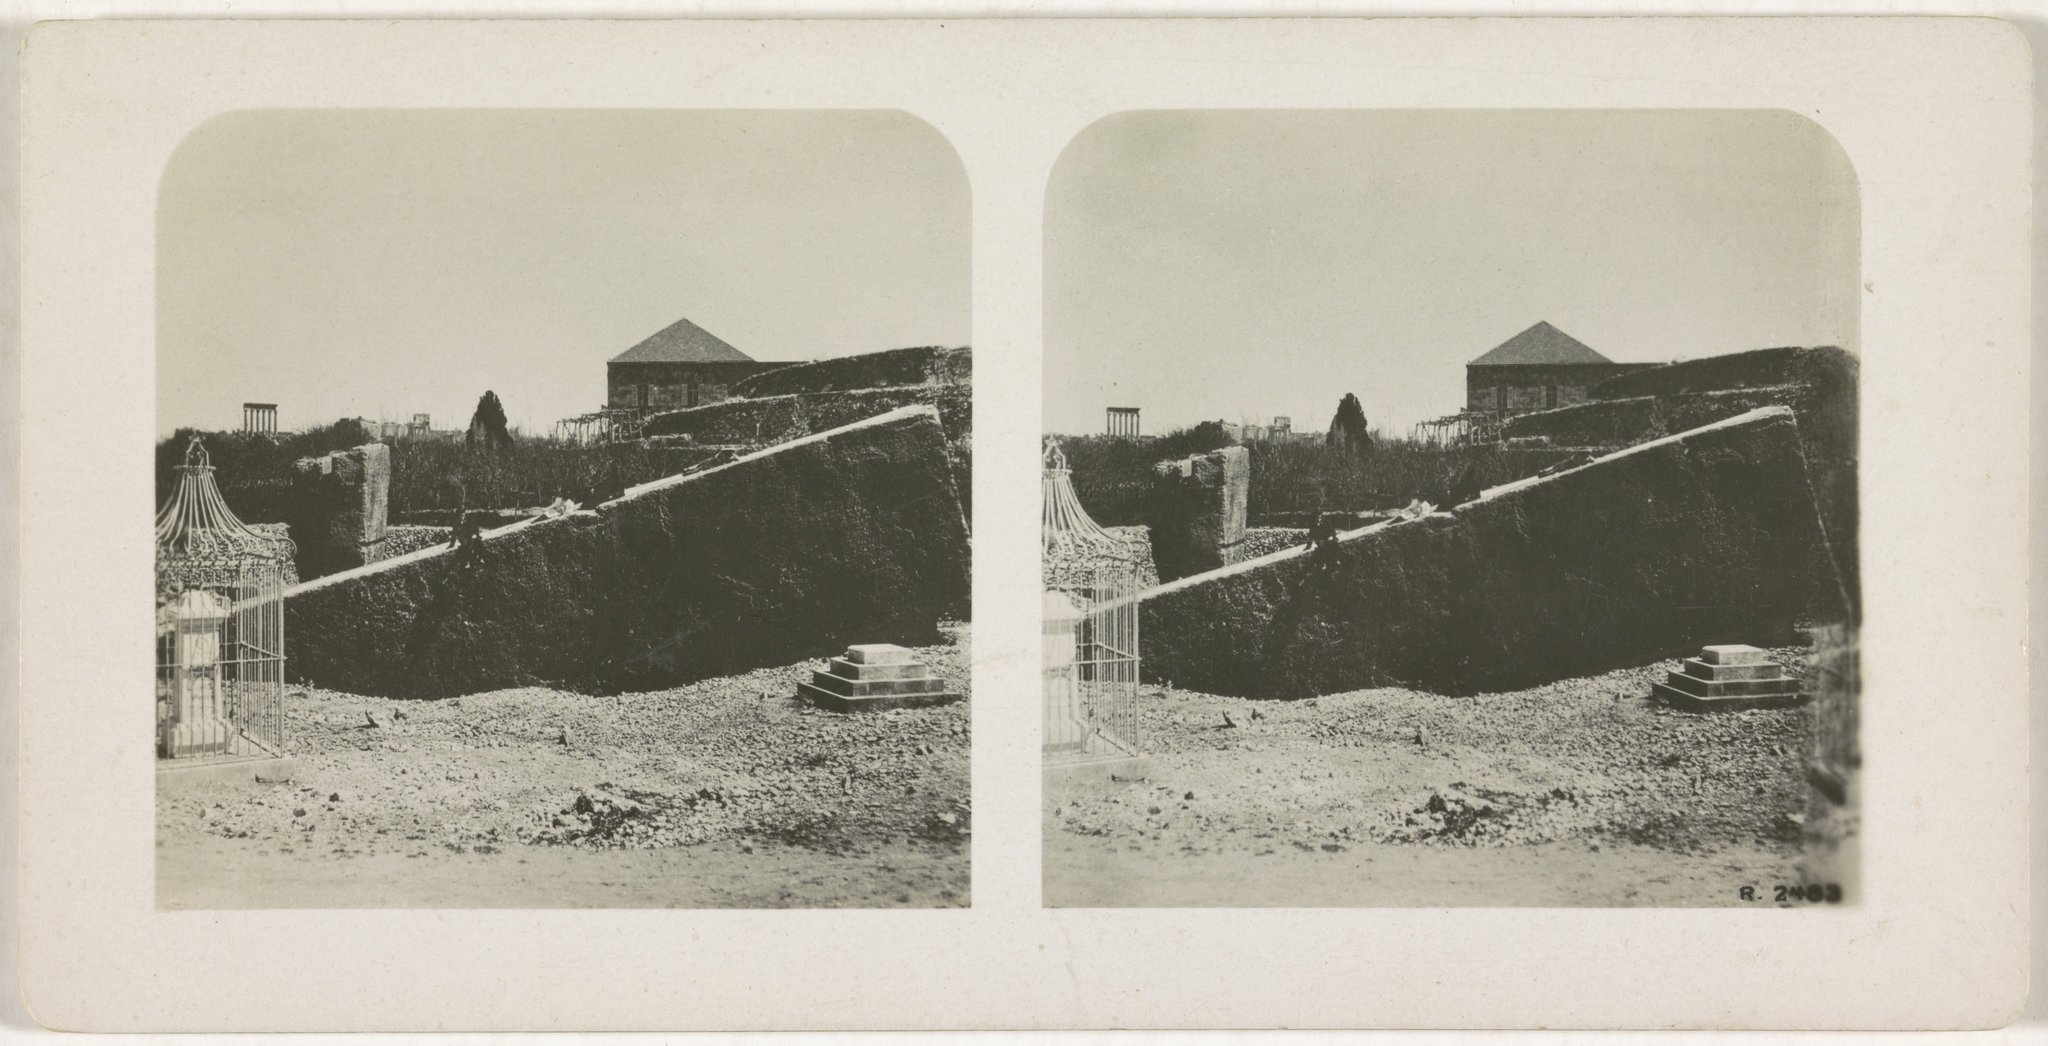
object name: stereograph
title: Steen der Zwangeren in de steengroeve van Baalbek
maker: Anonymous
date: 1884-1914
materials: cardboard, paper, photographic support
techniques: gelatin silver print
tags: baalbek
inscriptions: label: ‘2483. Baalbeck. Der Stein der Schwangeren im Steinbruch von B. / Baalbeck. The Stone of the Pregnant in the quarry of B.’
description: Rechtsonder op de foto rechts staat: R.2483.